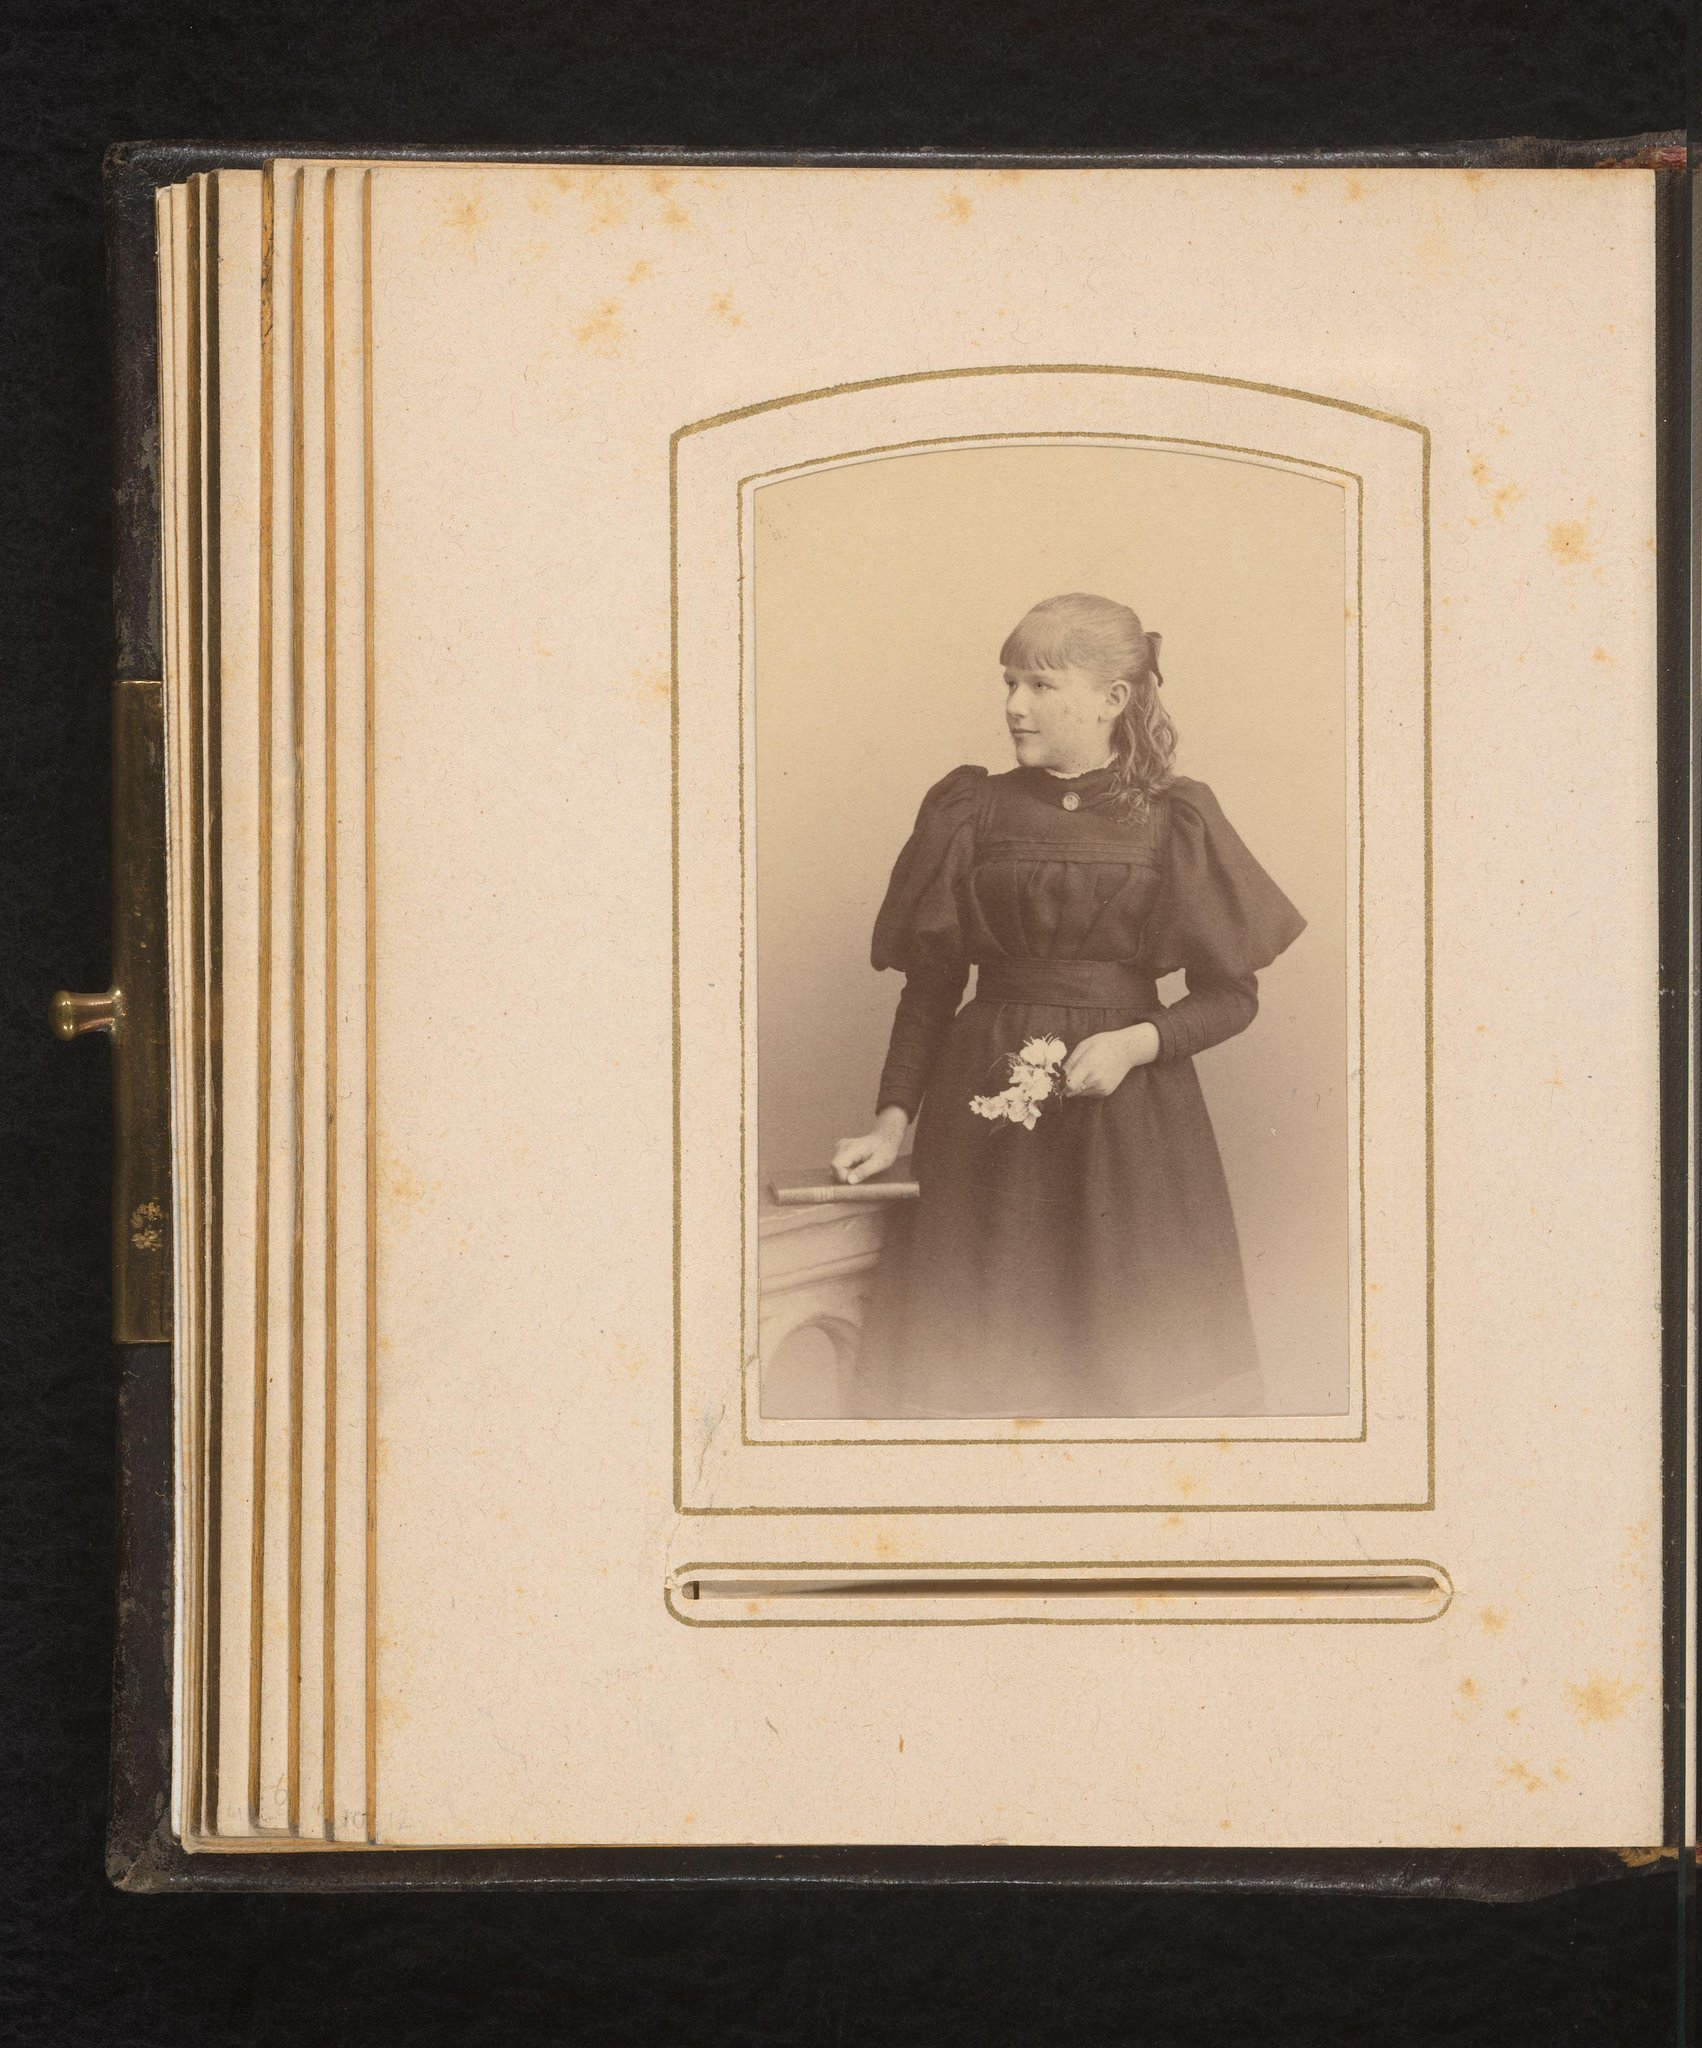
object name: photograph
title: Portret van een meisje met bloemen in de hand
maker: jean baptiste feilner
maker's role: fotograaf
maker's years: 1844-1912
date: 1875-1899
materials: cardboard, photographic support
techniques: albumen print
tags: flowers, historical persons, girl (child between toddler and youth)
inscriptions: inscription: ‘Jean Baptiste Feilner/ Hof-Photograph Sr. Königl Hoheit d/ Erbgrossherzogs v. Oldenburg/ Bremen/ Richtweg 6B parterre’